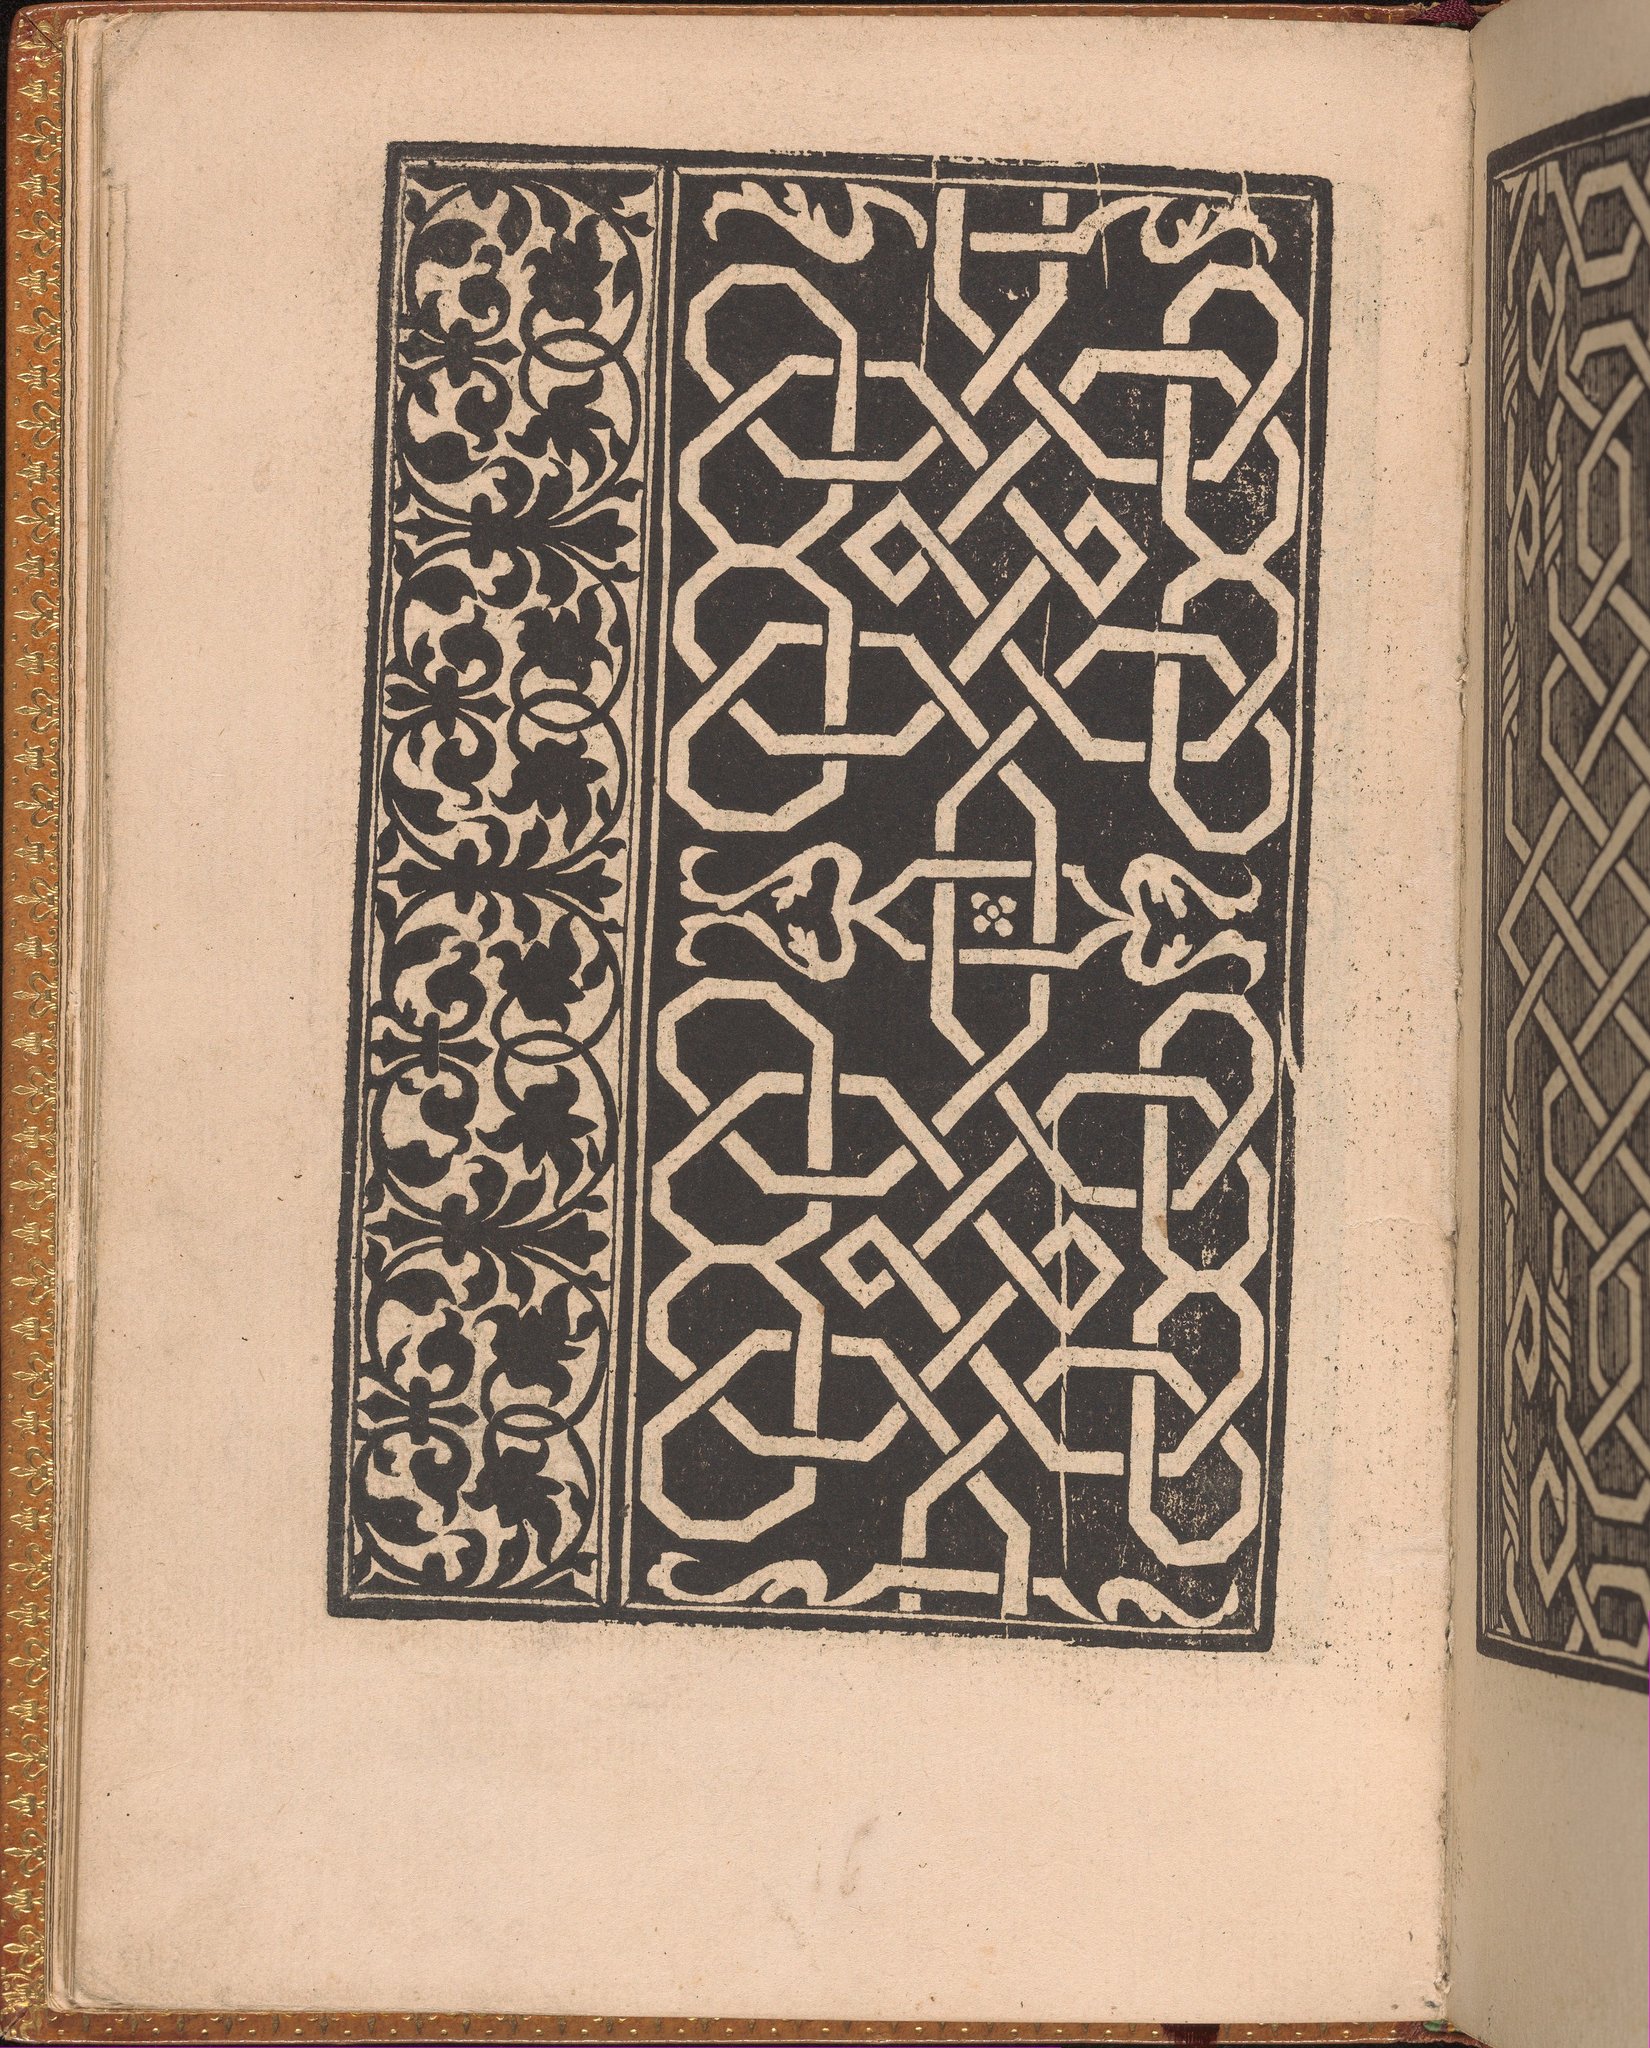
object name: book print ornament architecture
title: Convivio delle Belle Donne, page 12 (verso)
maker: nicolò zoppino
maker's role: publisher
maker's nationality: italian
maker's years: 1478-1544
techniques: woodcut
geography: italy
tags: ornament